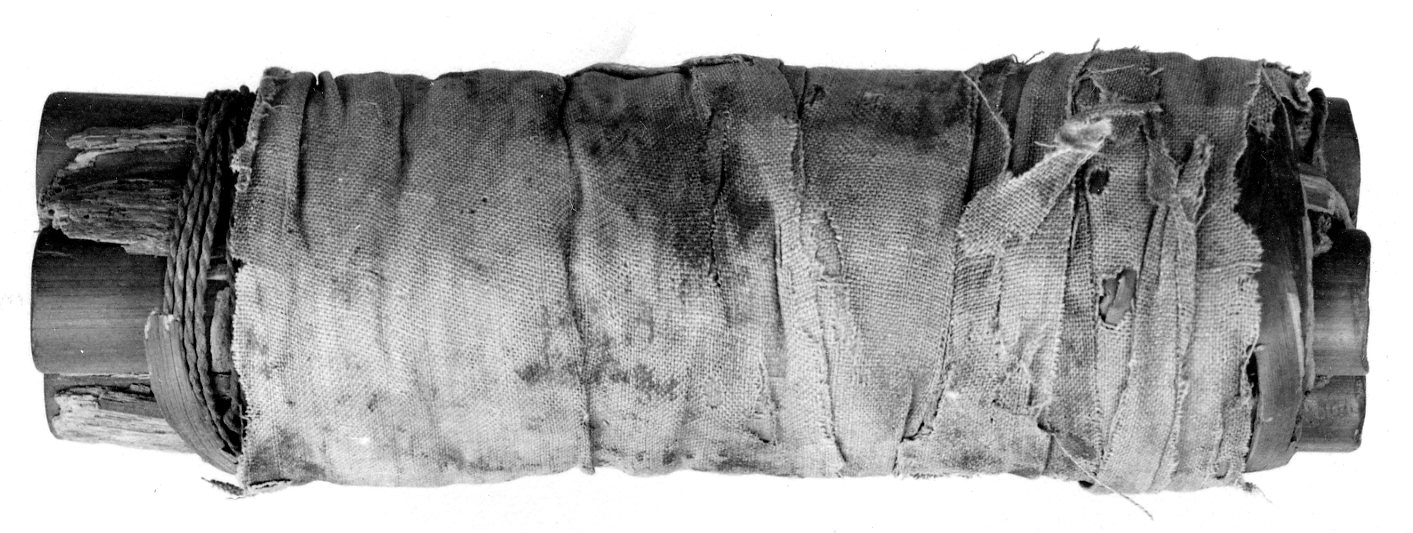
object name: kohl tube bundle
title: Bundle of Four Kohl Tubes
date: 1550-1295 BCE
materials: cord, linen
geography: egypt